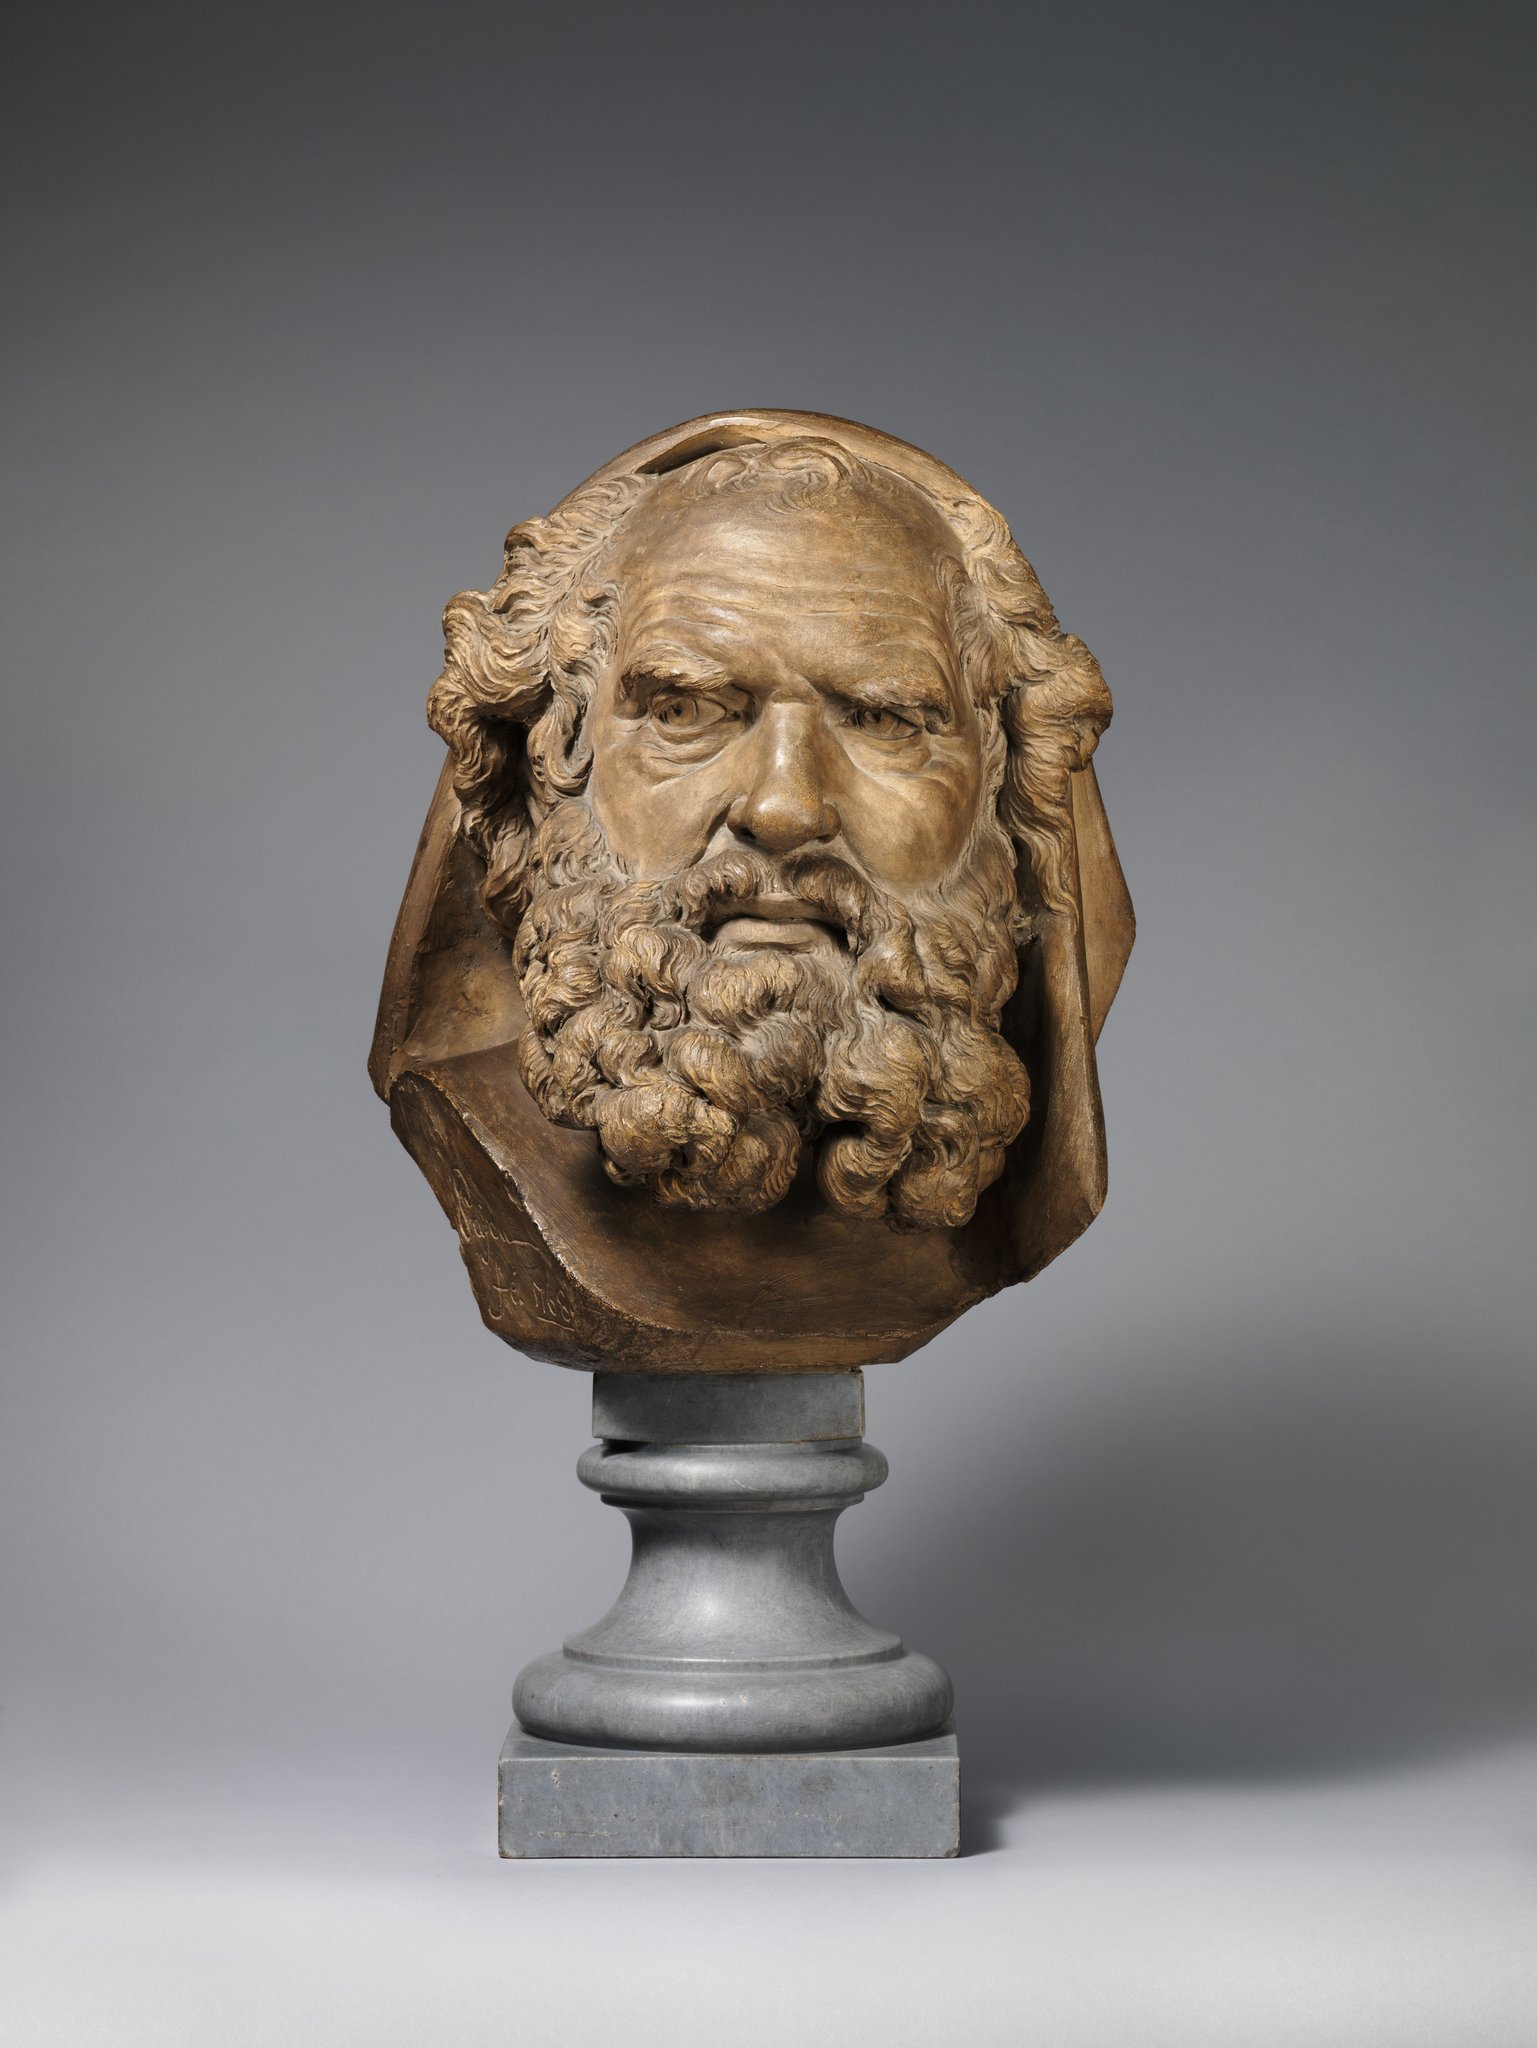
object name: bust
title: Head of a Bearded Elder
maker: augustin pajou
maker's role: artist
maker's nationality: french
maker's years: 1730-1809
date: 1768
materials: marble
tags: heads,men,portraits